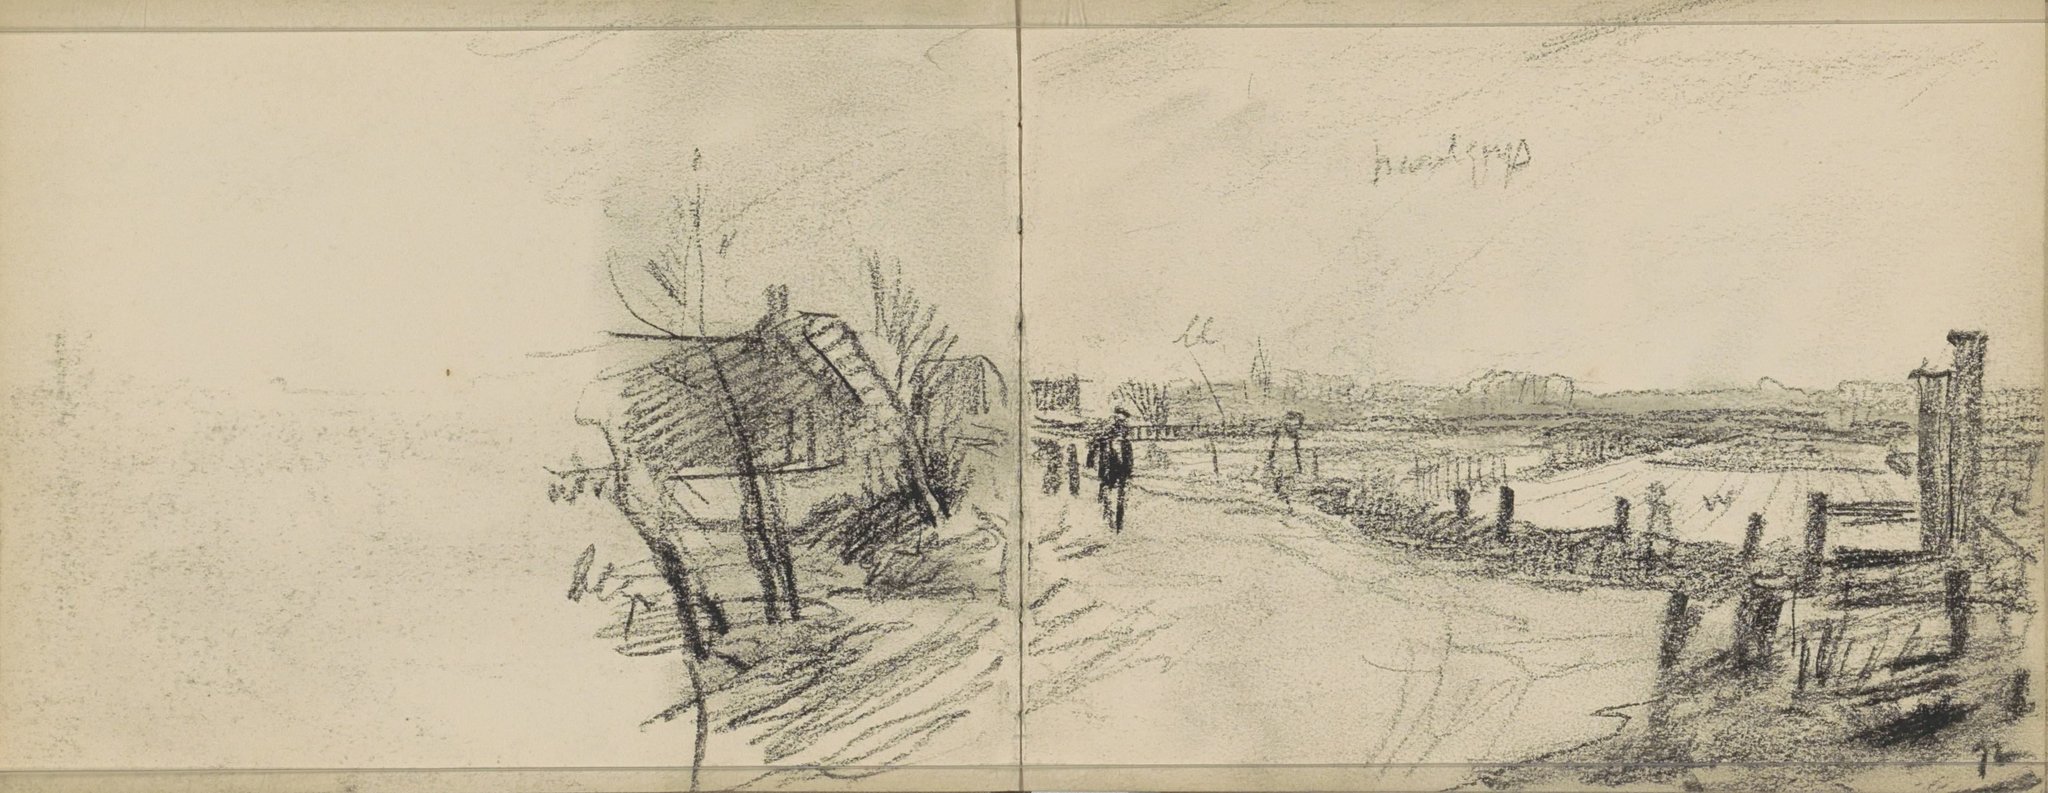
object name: sketchbook leaf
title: Weg langs velden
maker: johan antonie de jonge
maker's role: draughtsman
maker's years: 1864-1927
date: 1881-1927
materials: chalk, paper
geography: south holland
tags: adult man, rural housing, e.g. country-house, villa, cottage, cultivated land, road, path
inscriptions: kleurnotitie, handgeschreven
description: Links loopt een man over een weg langs huizen. Aan de andere kant van de weg liggen velden. Blad 1 verso en blad 2 recto uit een schetsboek met 34 bladen.